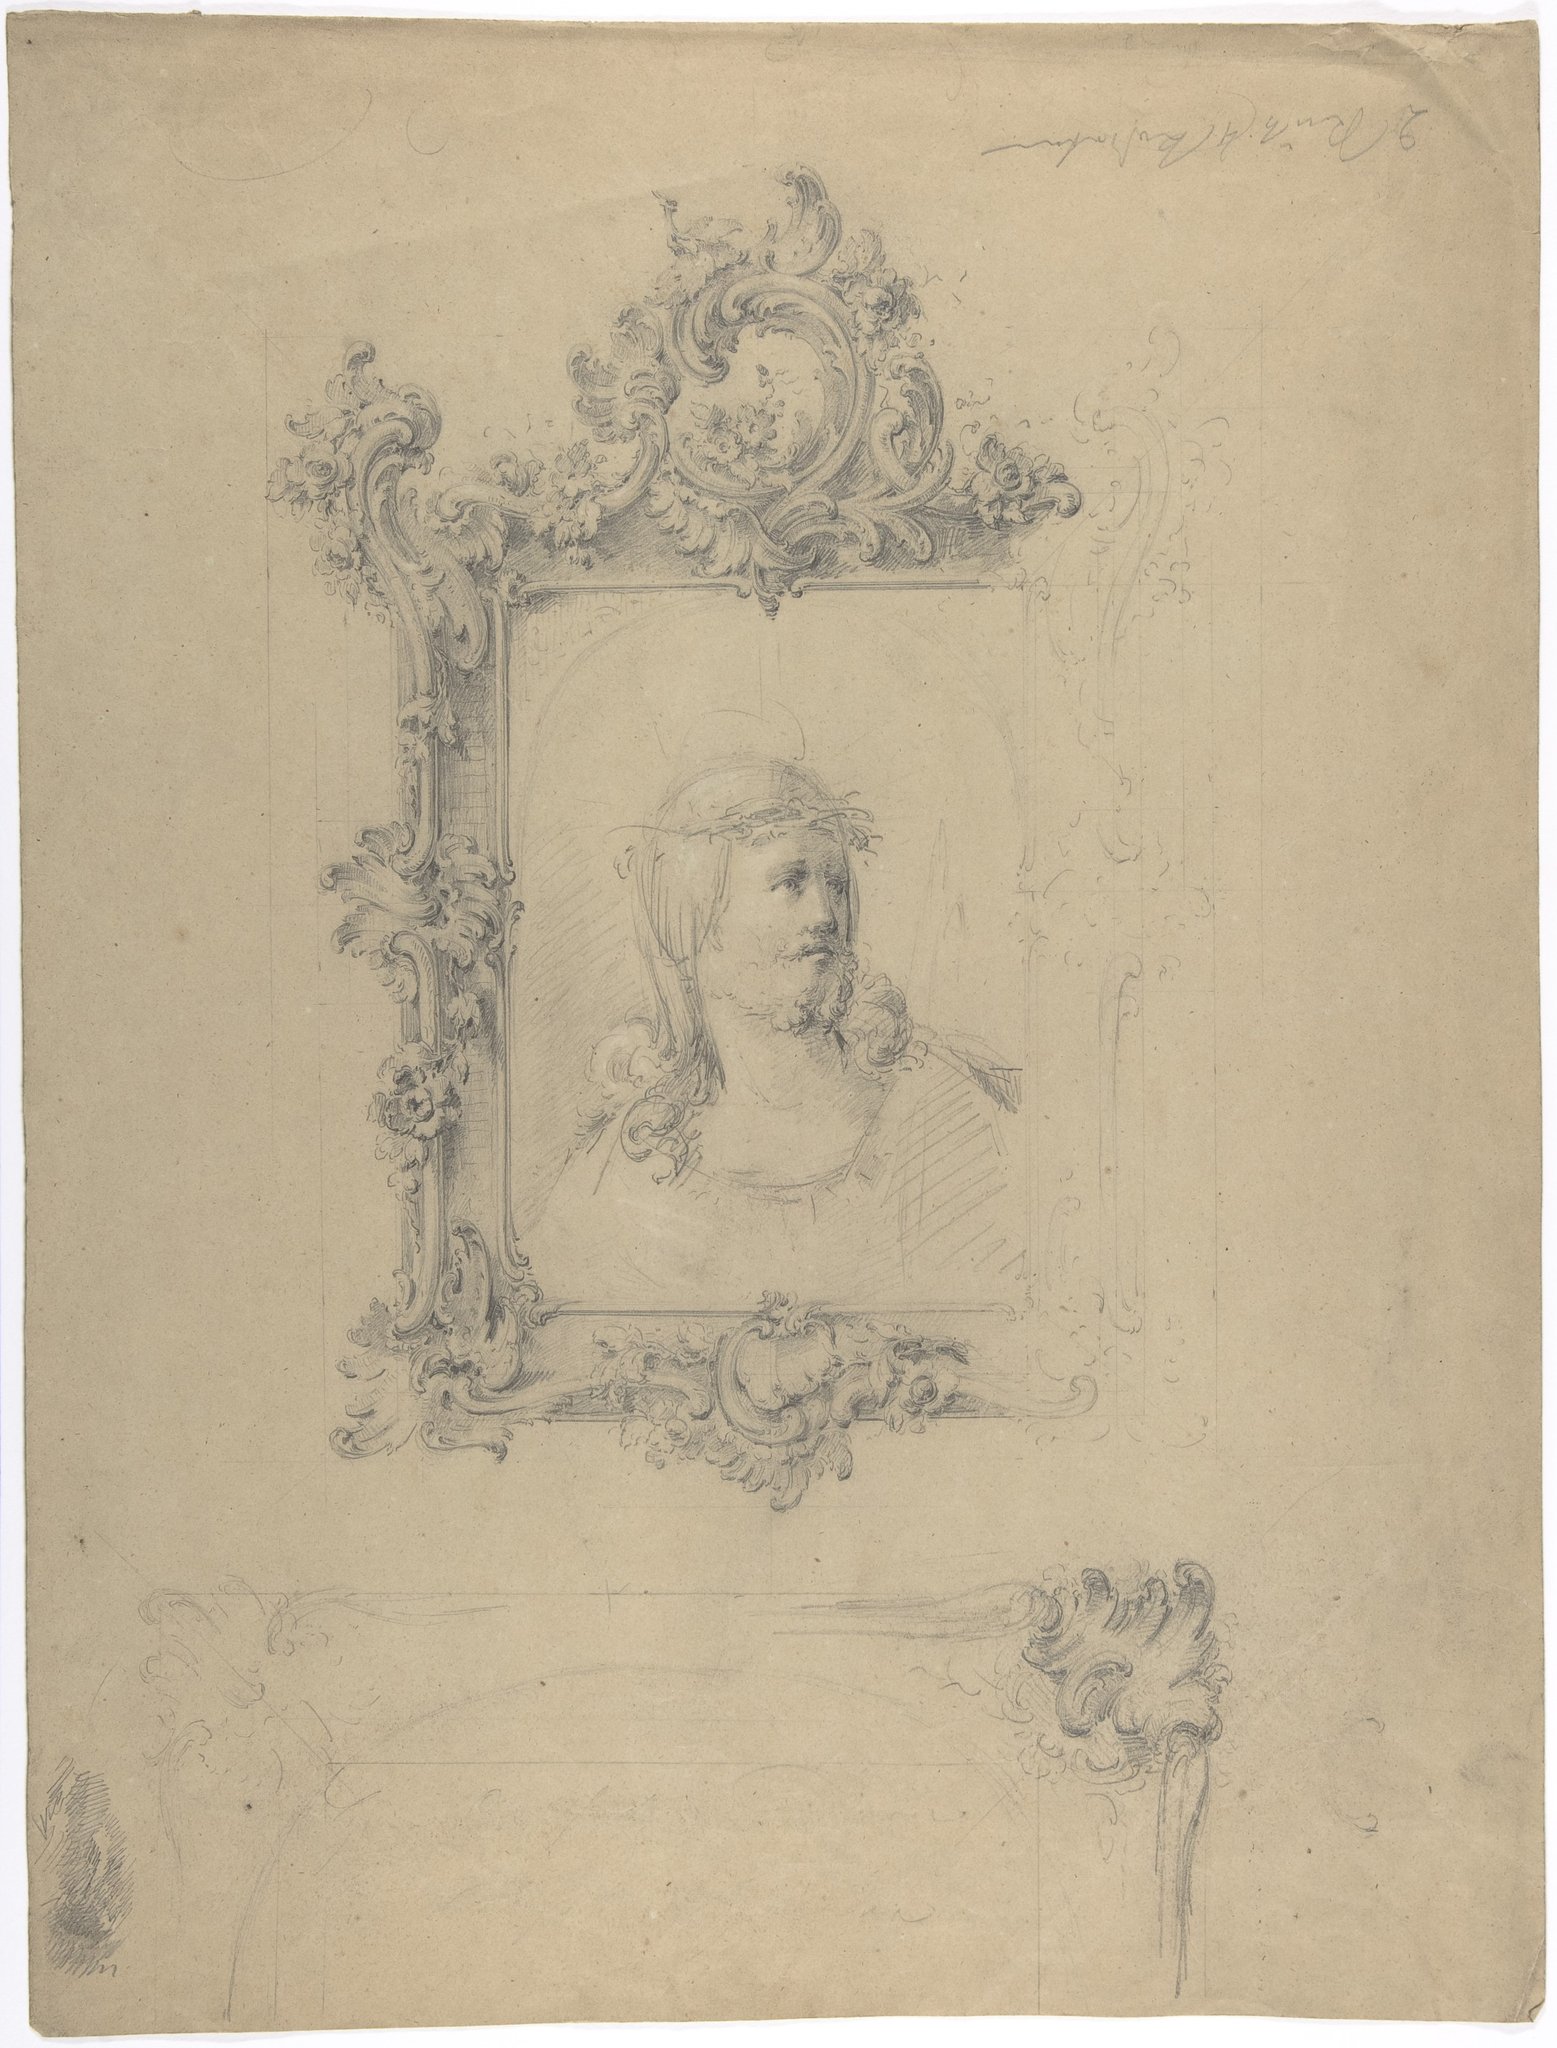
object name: drawing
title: Two Rococo Frames, with Christ as Man of Sorrows in Upper Design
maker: anonymous, british, 19th century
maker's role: artist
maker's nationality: british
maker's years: 1800-1900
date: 1801-1900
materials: graphite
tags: ornament,christ